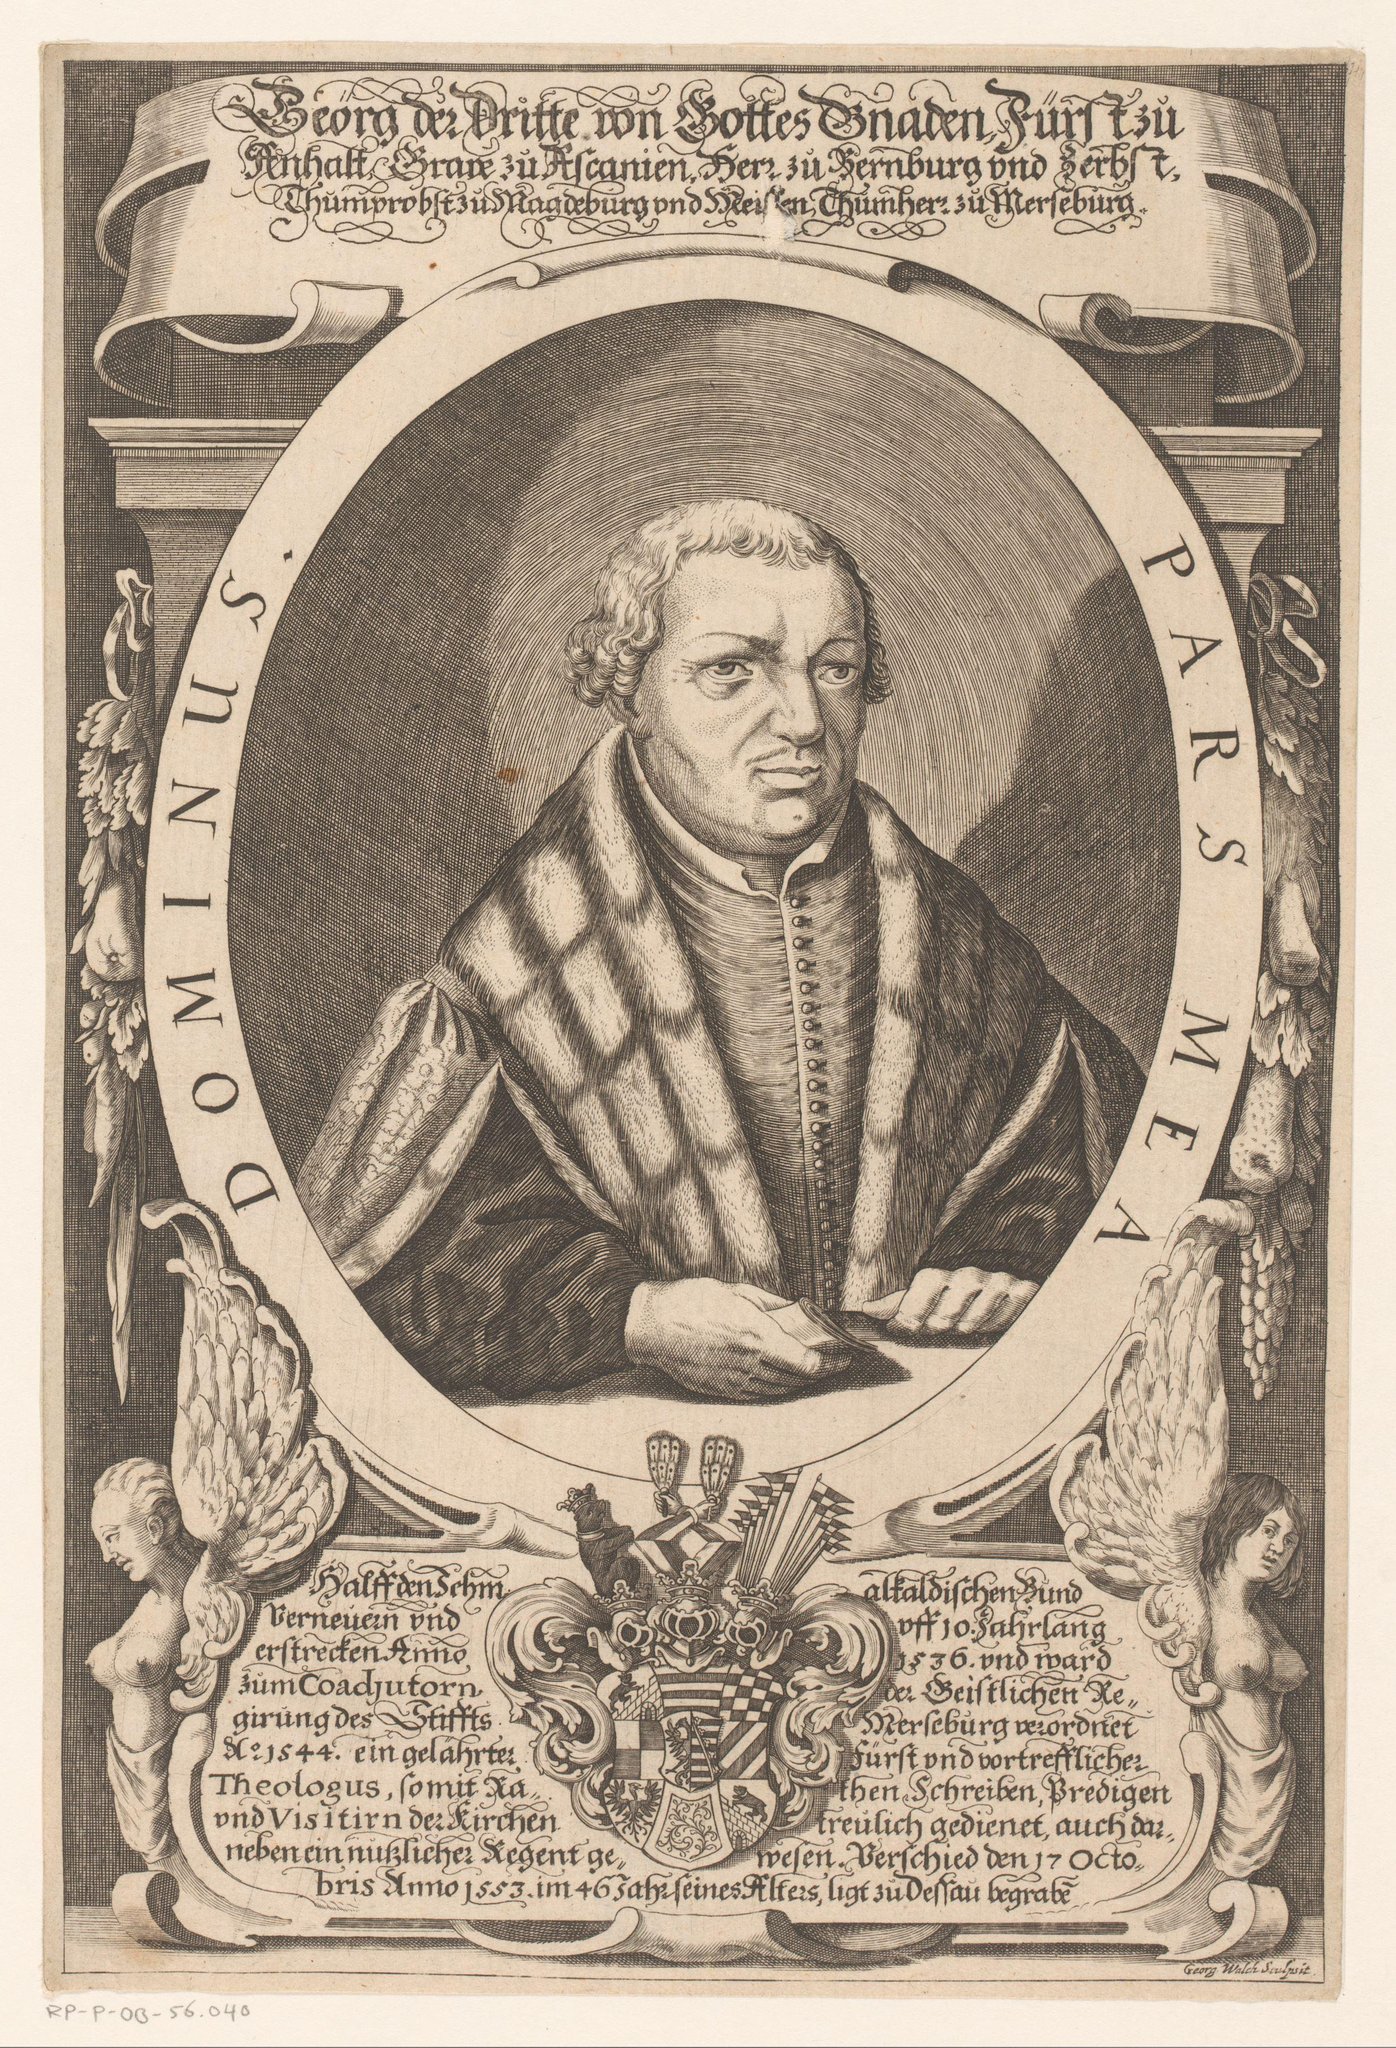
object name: print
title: Portret van Georg III, prins van Anhalt-Dessau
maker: georg walch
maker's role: print maker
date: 1632-1654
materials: paper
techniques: engraving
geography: germany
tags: historical persons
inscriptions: collector's mark: Lugt 2228